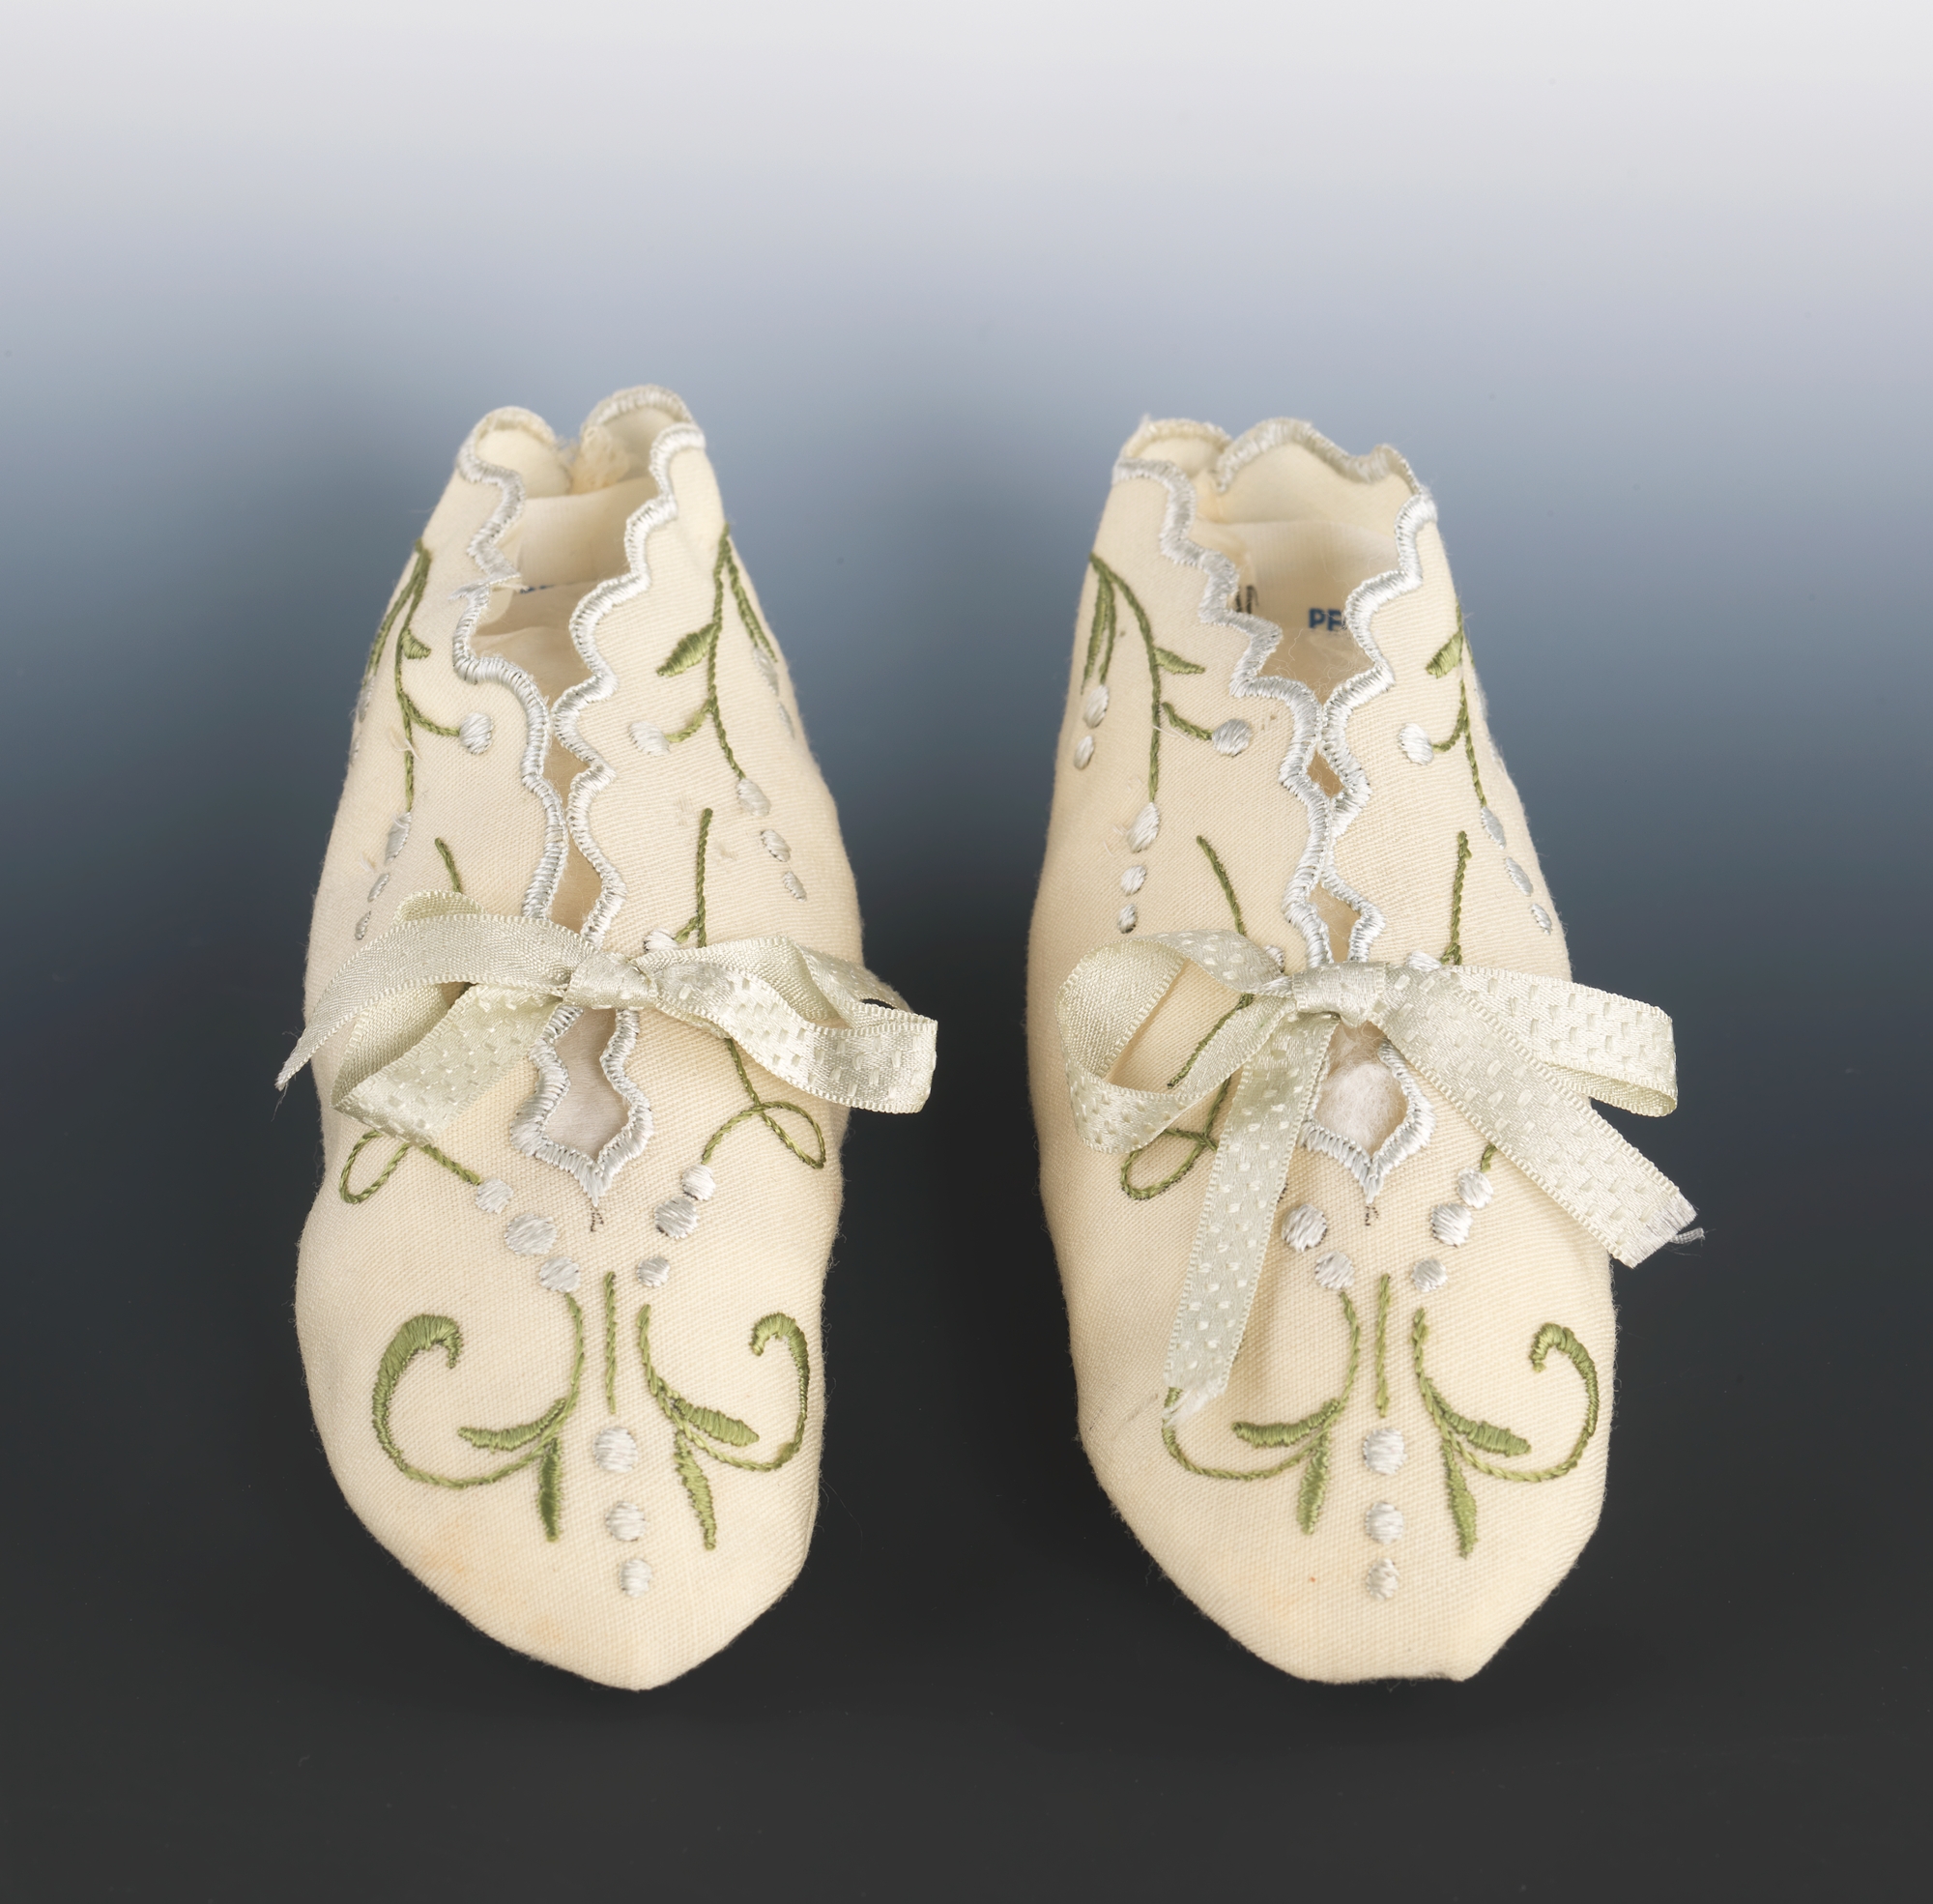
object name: bootee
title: Bootees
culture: american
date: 1870-1890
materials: silk, wool